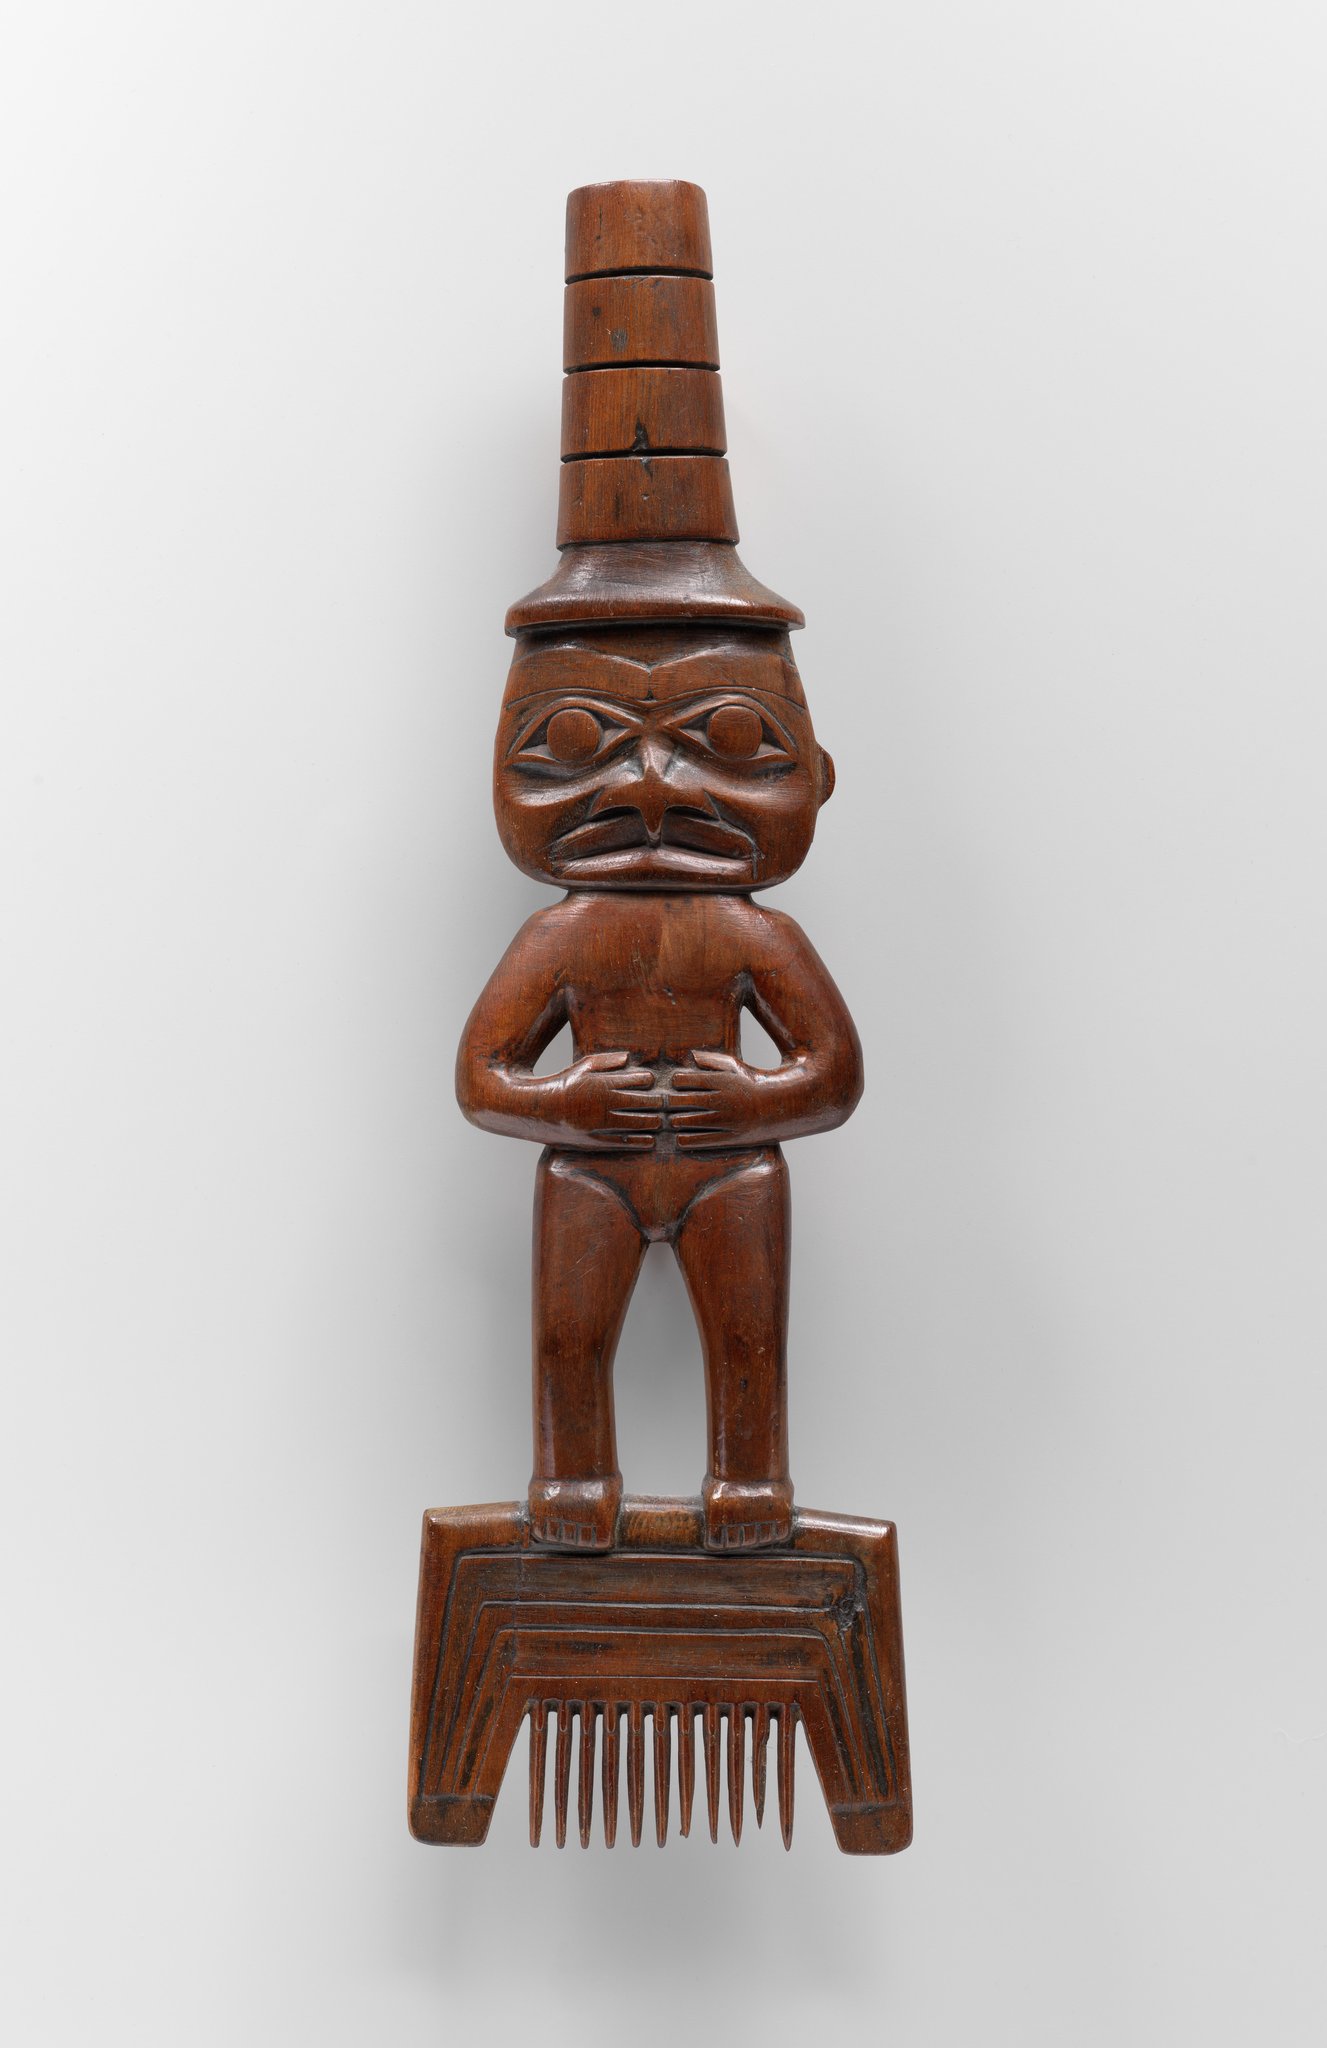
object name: comb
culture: tlingit or native american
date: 1850-1880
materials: wood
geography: united states